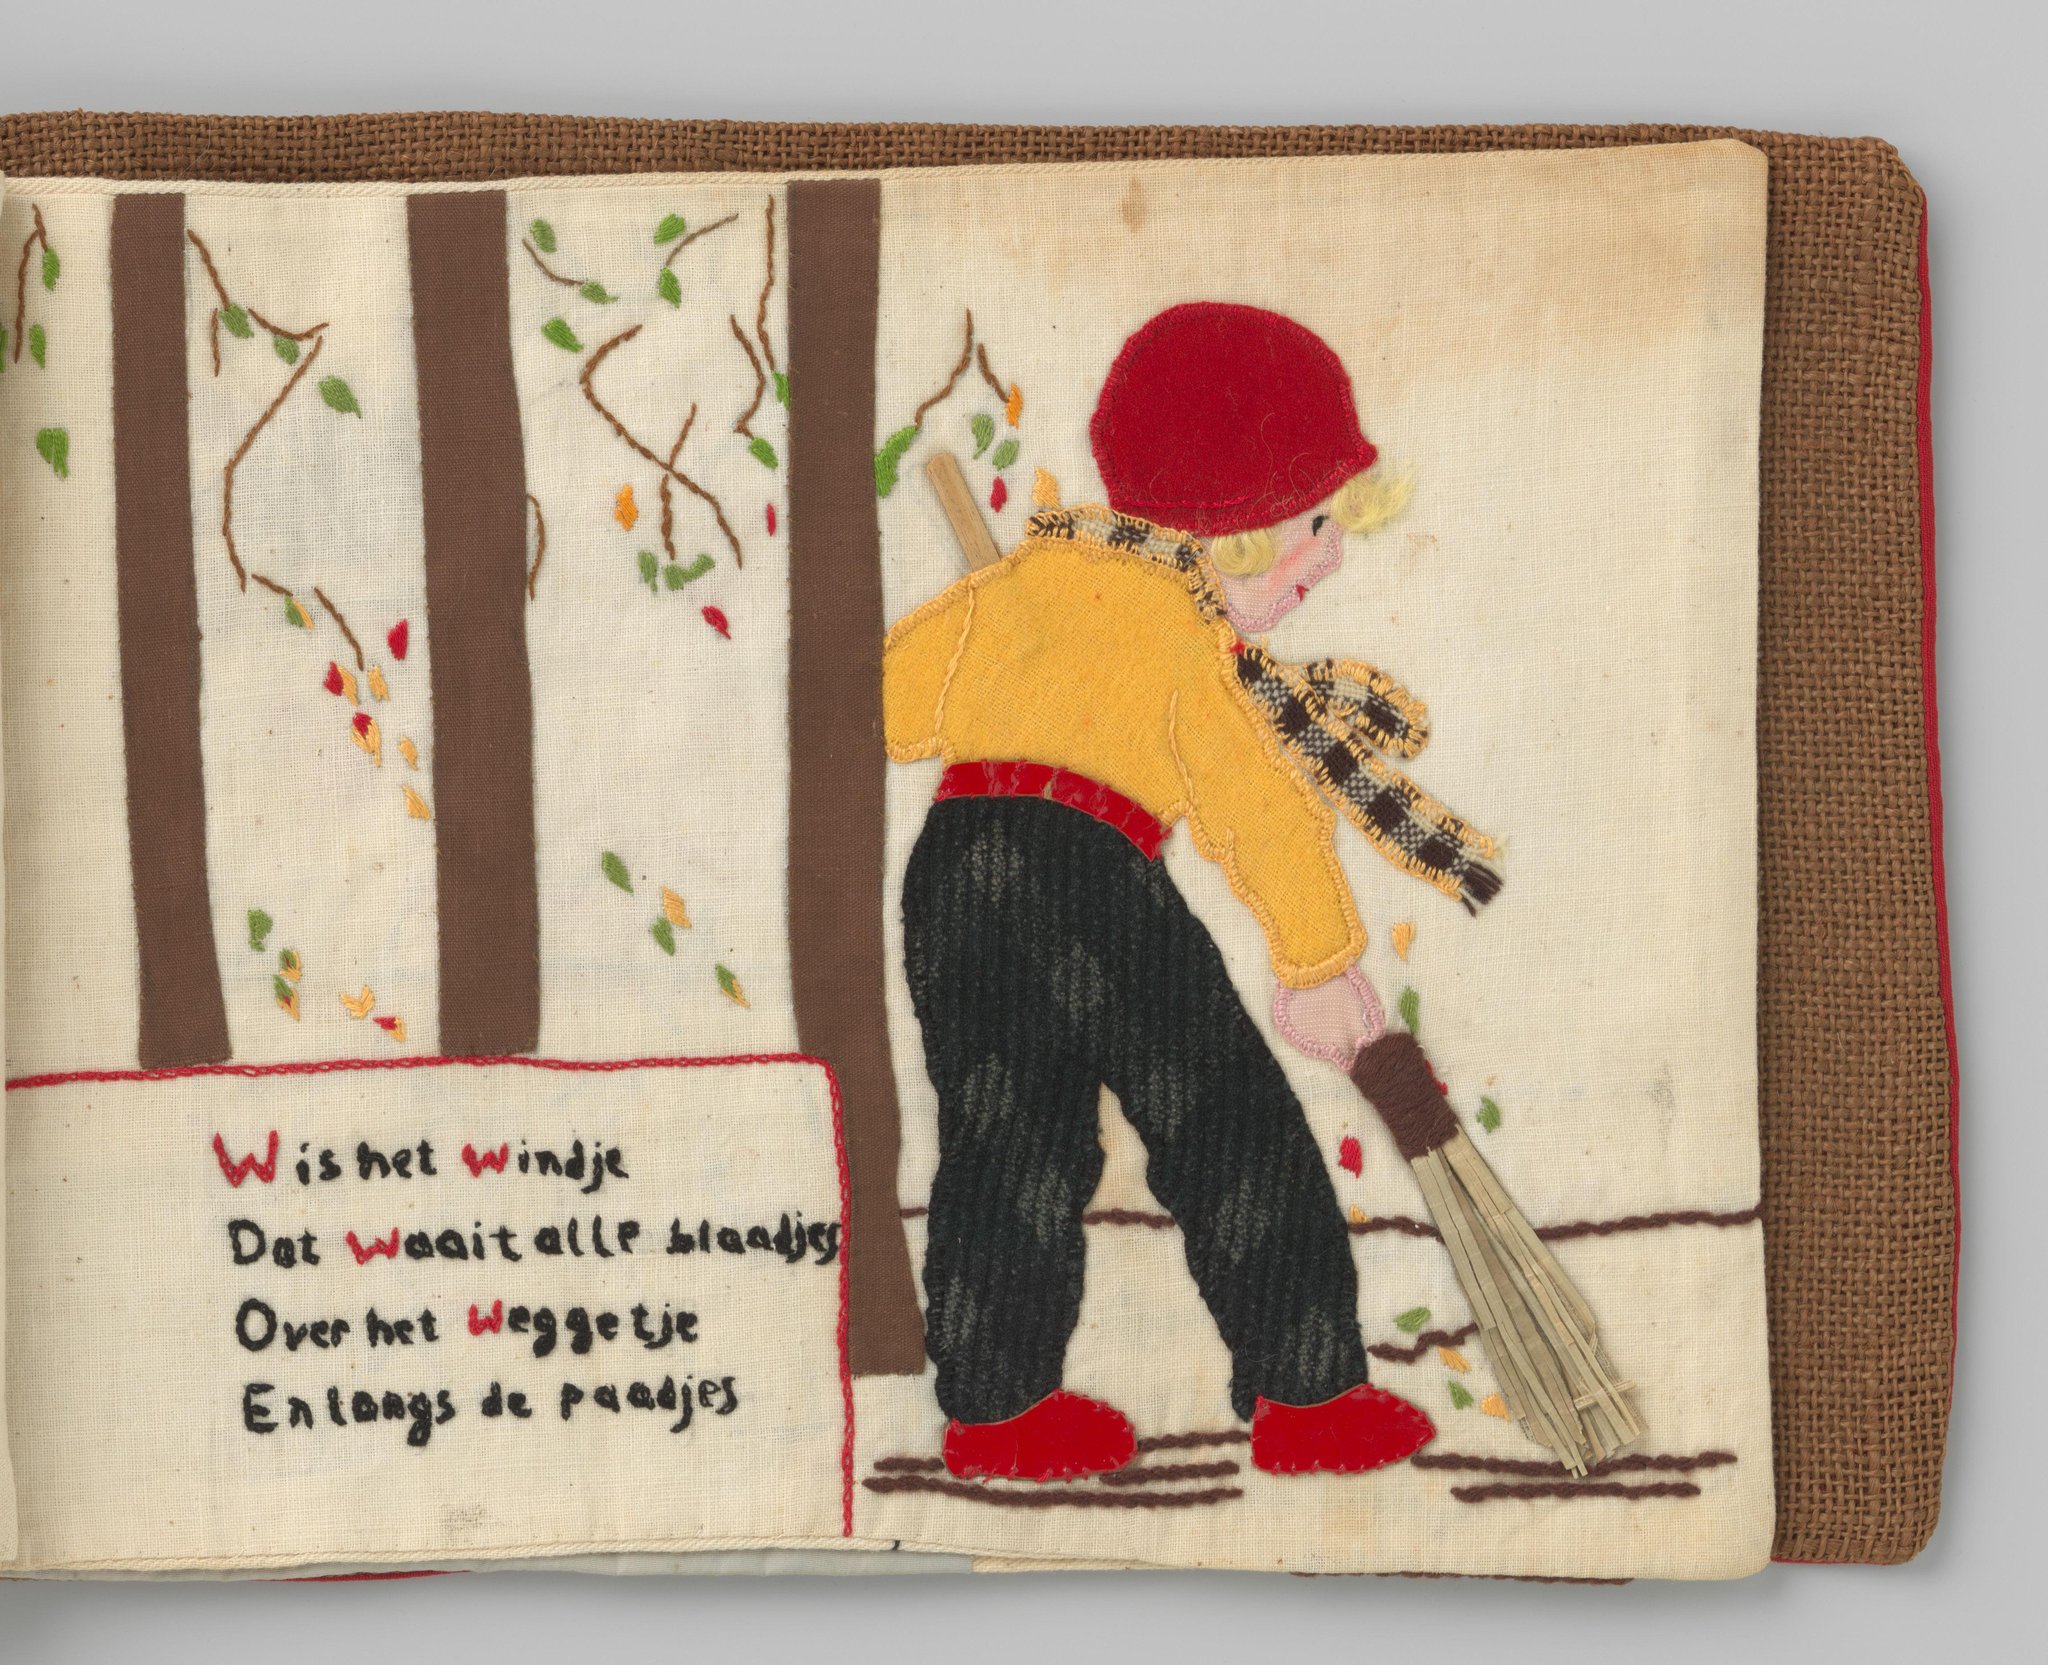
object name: blad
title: W is het Windje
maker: miesje geertruida maria petronella aalbersberg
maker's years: 1915-1997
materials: cotton, textile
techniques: appliqué, embroidered, stitch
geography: brastagi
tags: reading, book in which illustrations are essential, letters, alphabet, script, internment camp, nursery school (+ teaching aids), (other forms of) needlework, e.g.: crocheting, knitting, embroidering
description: In het geheim gemaakt kinderboek in textiel vrij naar A is een Aapje van Rie Cramer. Het werd gezamenlijk gemaakt door de vrouwelijke gevangenen van het Japanse interneringskamp Brastagi, een oude plantage in Noord-Sumatra 60 kilometer ten zuiden van Medan aan de weg naar het Toba-meer, tijdens de Tweede Wereldoorlog ter gelegenheid van de vijfde verjaardag van Pem Hagers, de dochter van Miesje Hagers-Aalbersberg die de ontwerptekeningen en sjablonen had gemaakt.